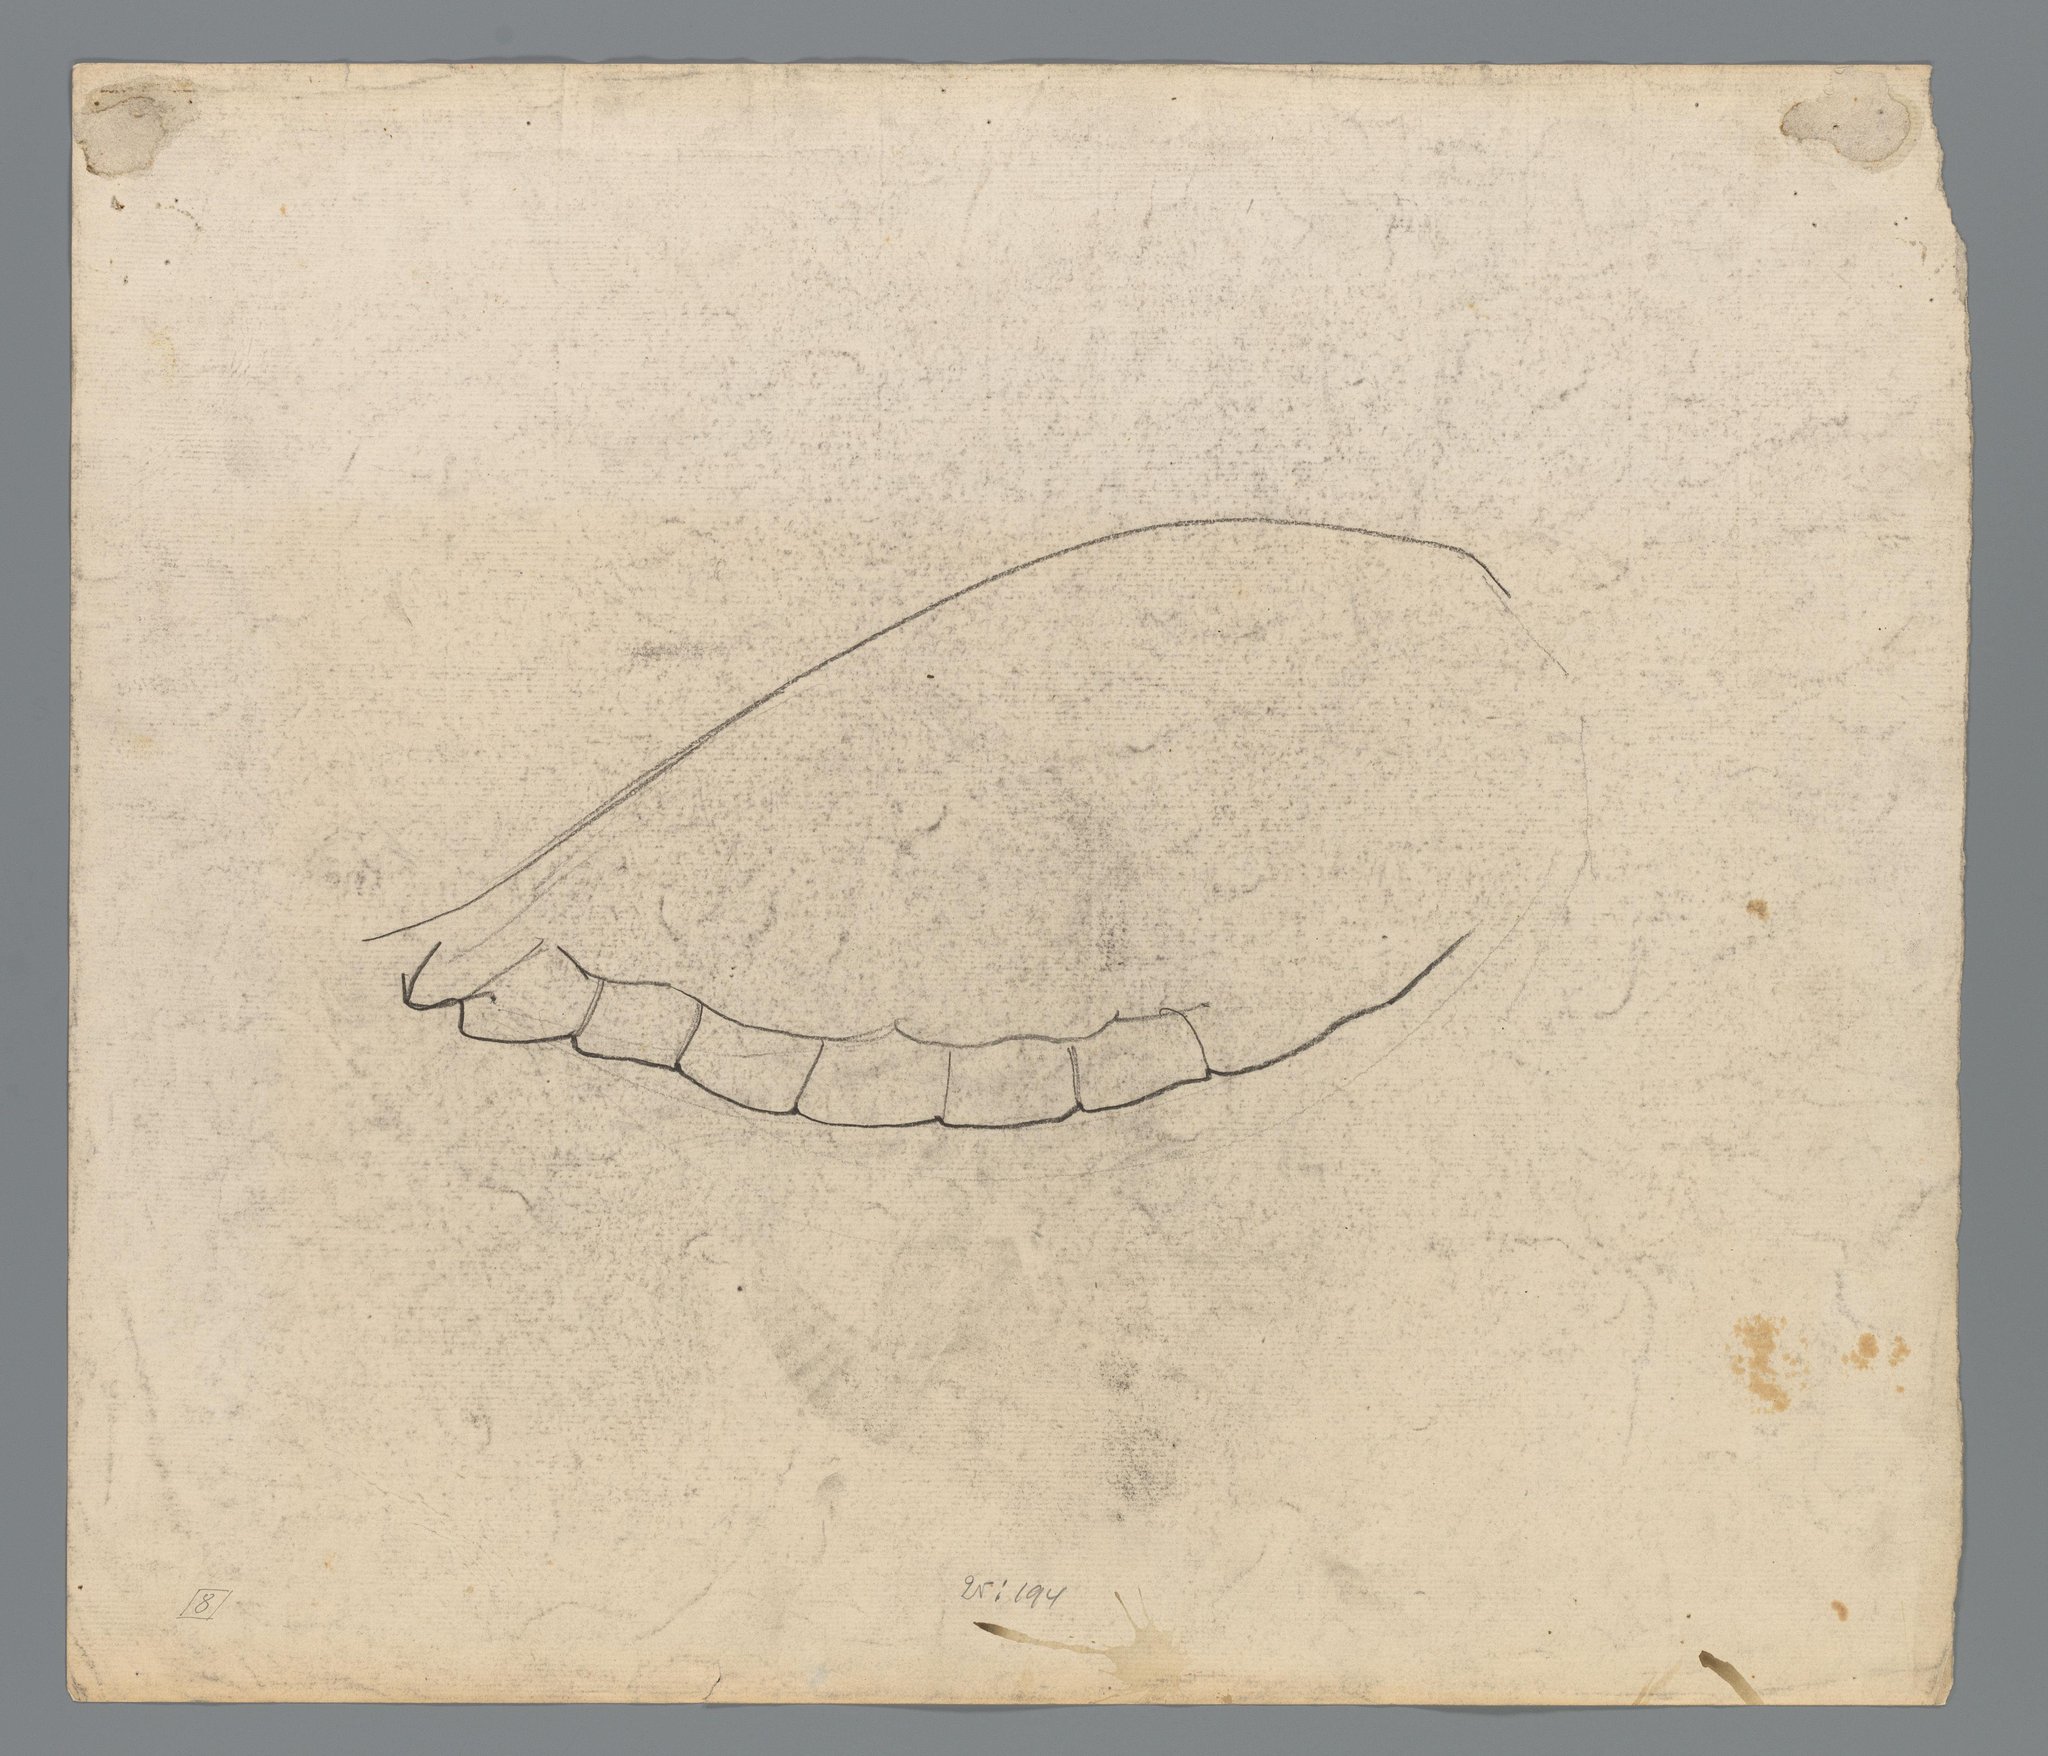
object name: drawing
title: Studie van een schilpaddenschild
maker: gerrit willem dijsselhof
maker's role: designer, draughtsman, print maker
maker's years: 1866-1924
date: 1876-1924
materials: charcoal, paper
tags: tortoises, turtles (+ shell, snail-shell etc.)